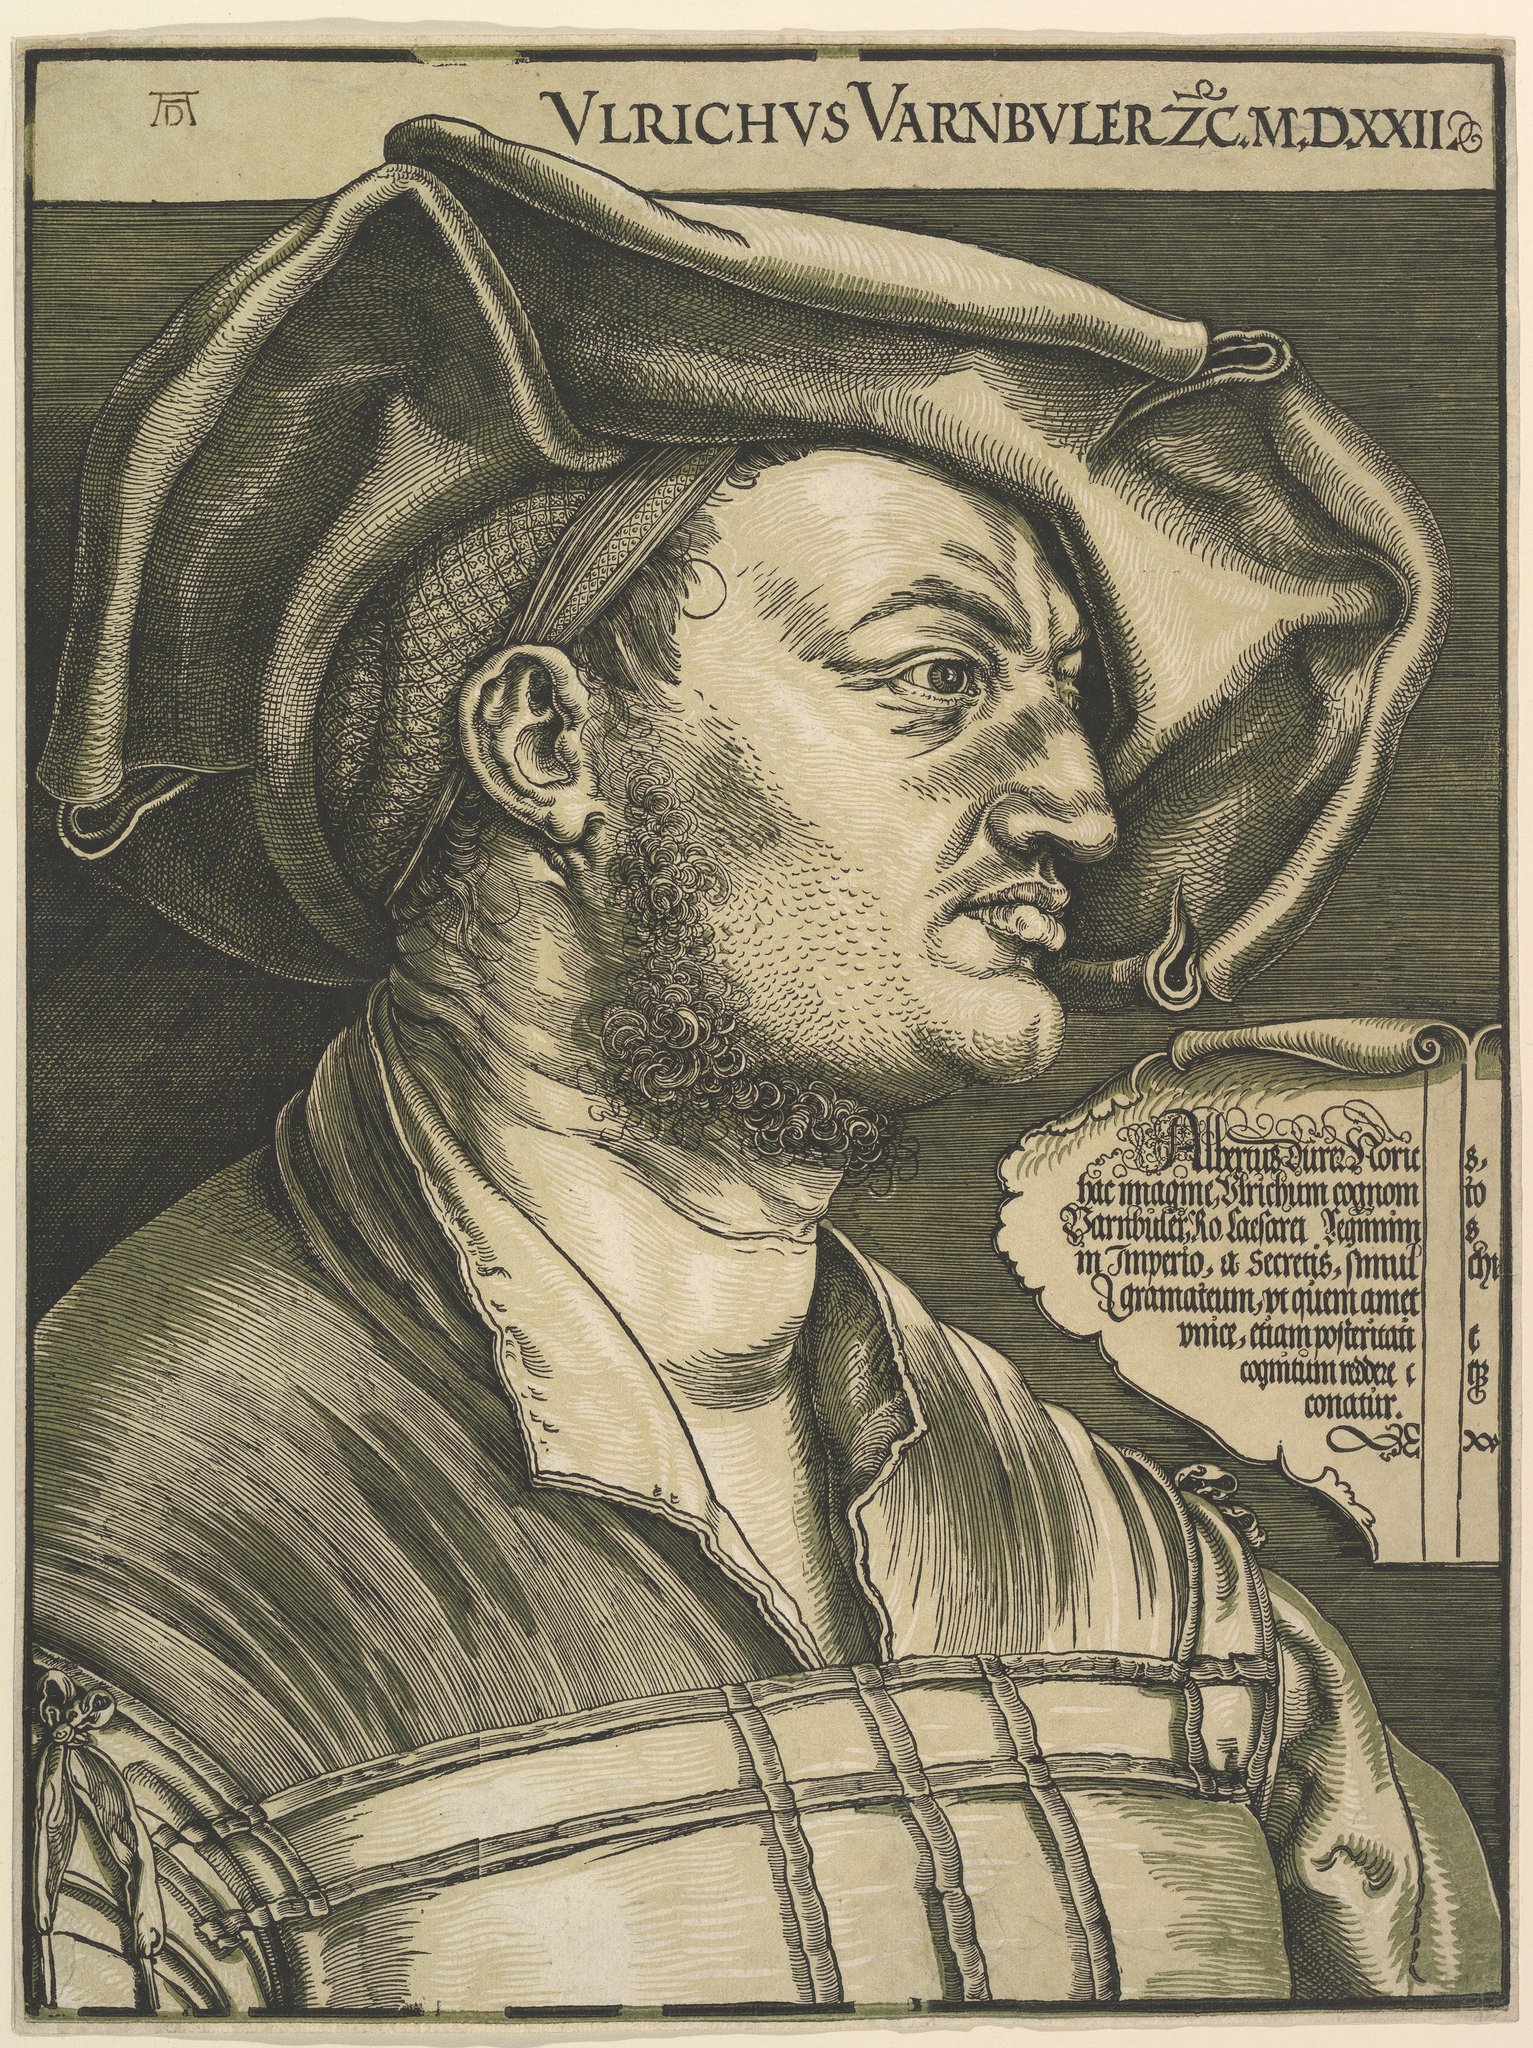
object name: print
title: Portrait of Ulrich Varnbuler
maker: albrecht dürer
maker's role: artist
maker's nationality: german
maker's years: 1471-1528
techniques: woodcut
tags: men,profiles